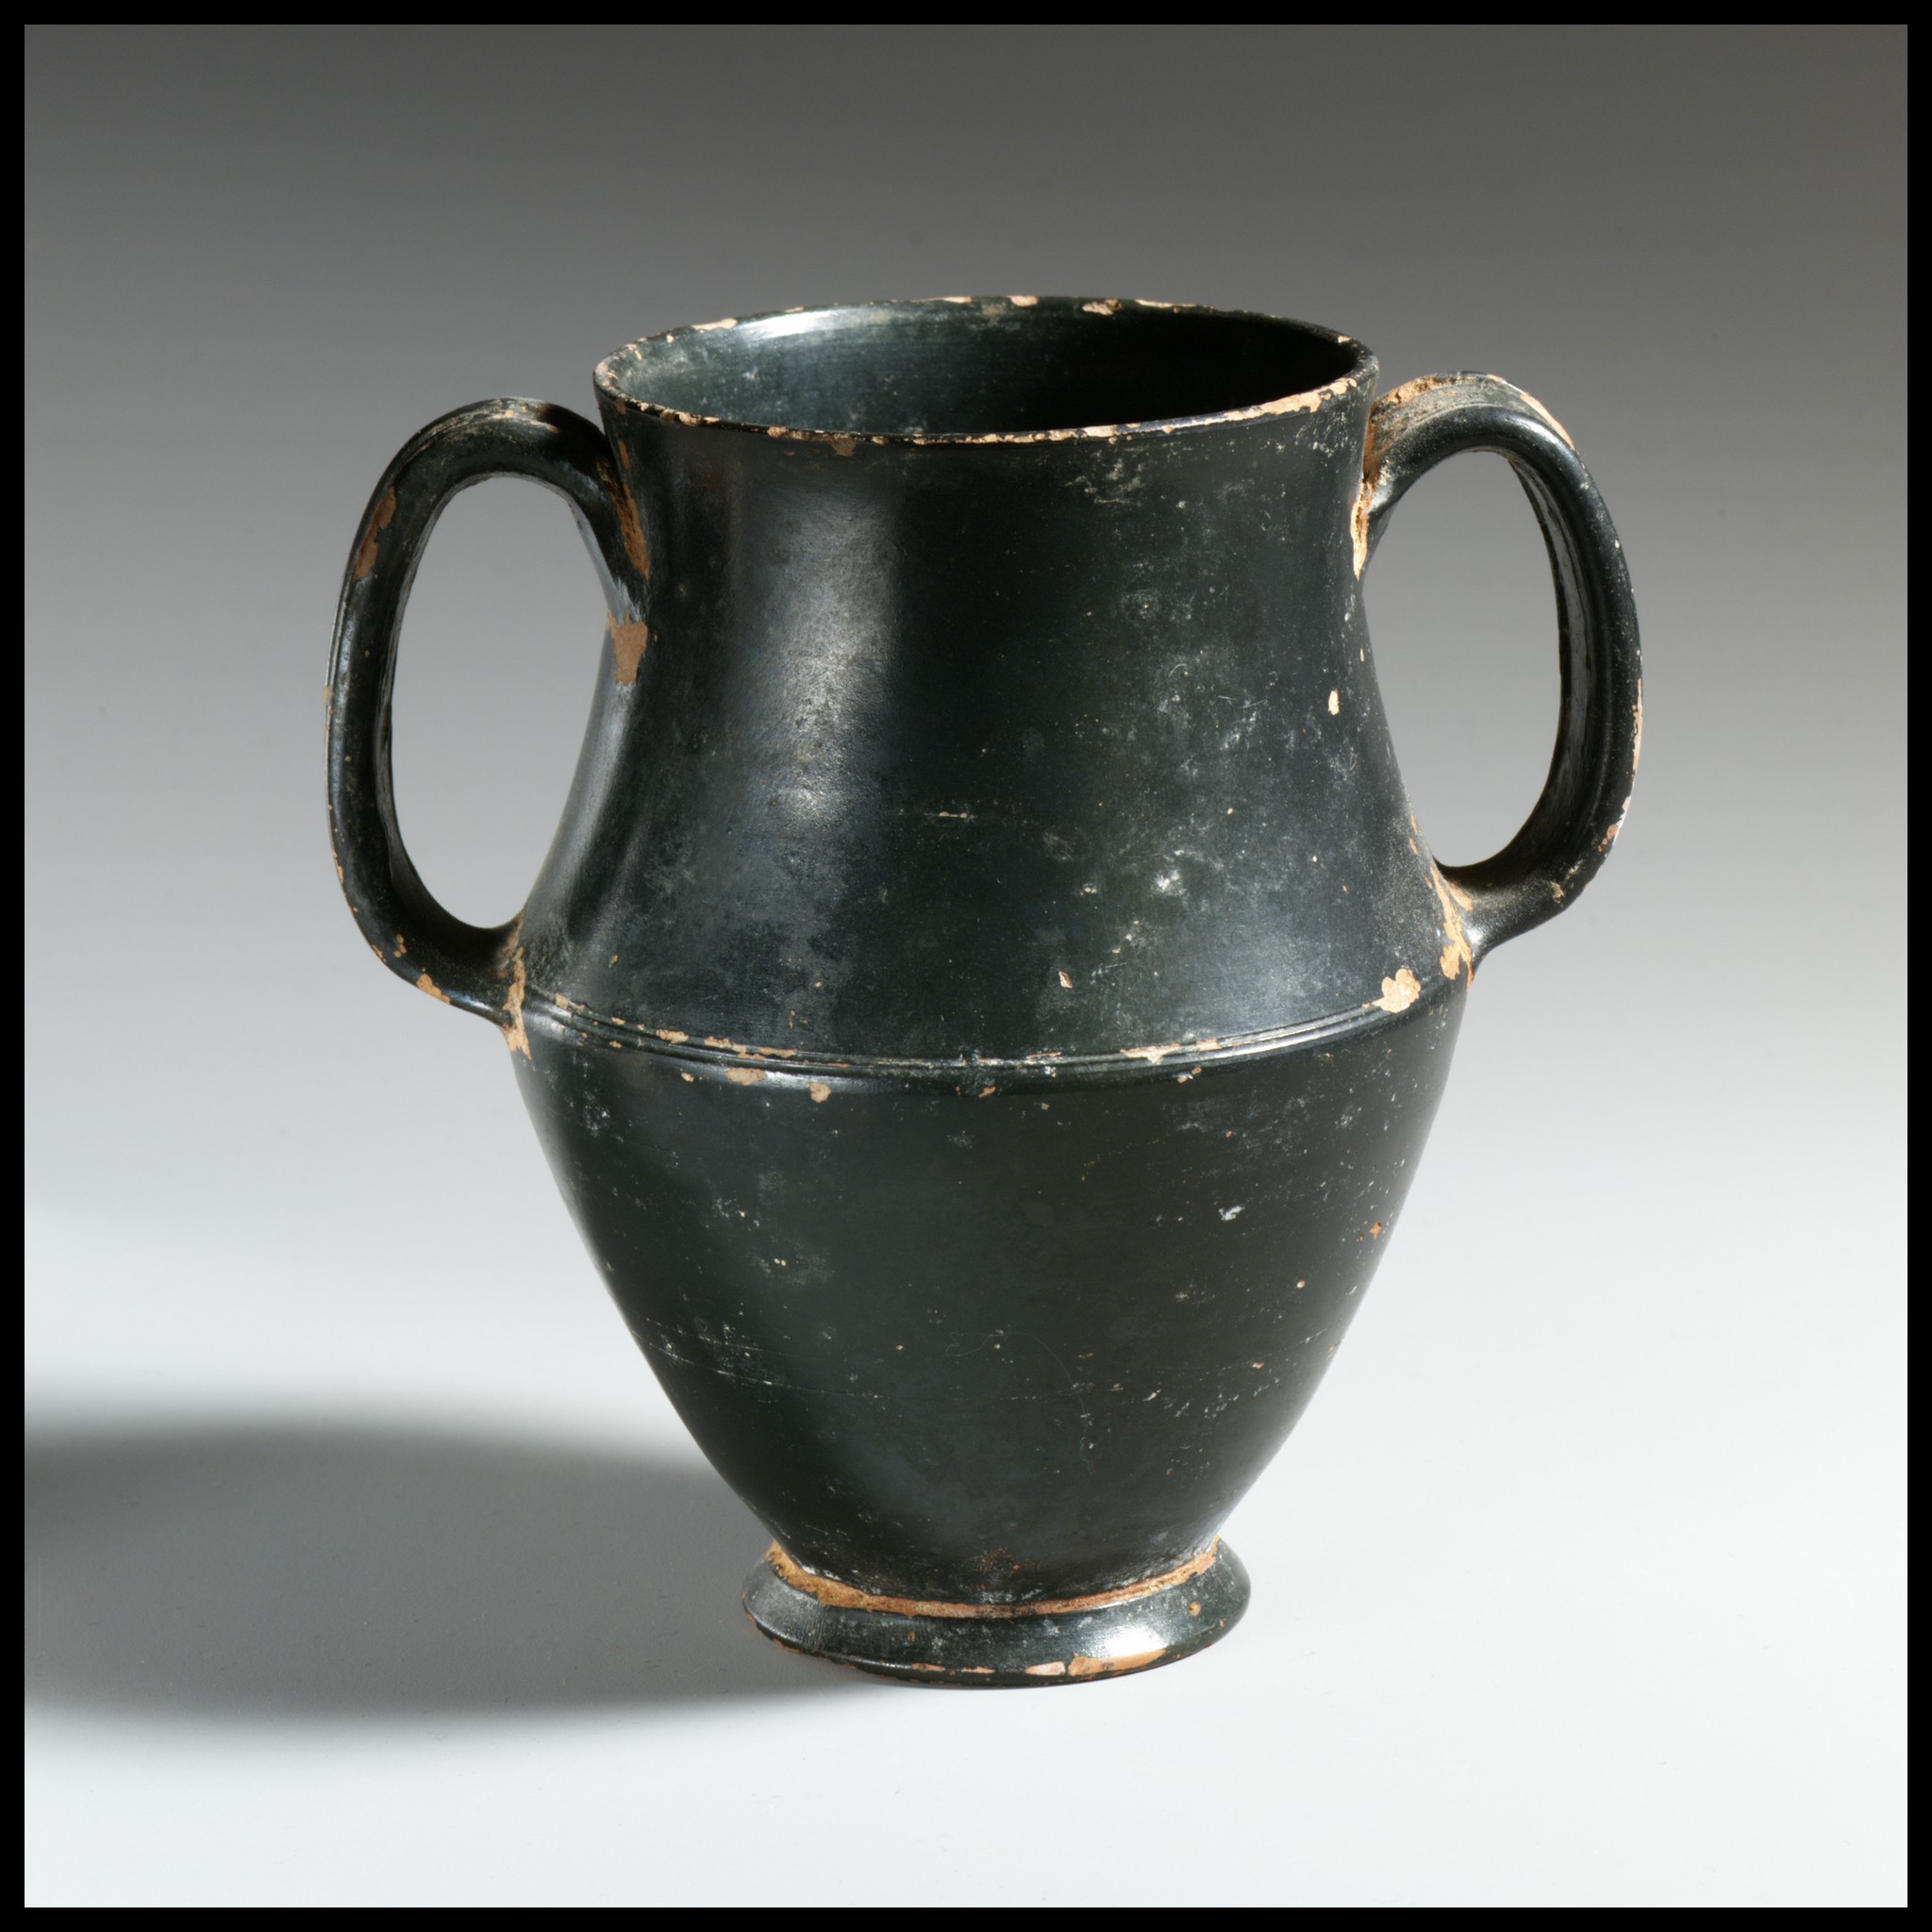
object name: mug, two handle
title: Terracotta mug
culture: etruscan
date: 400-301 BCE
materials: terracotta